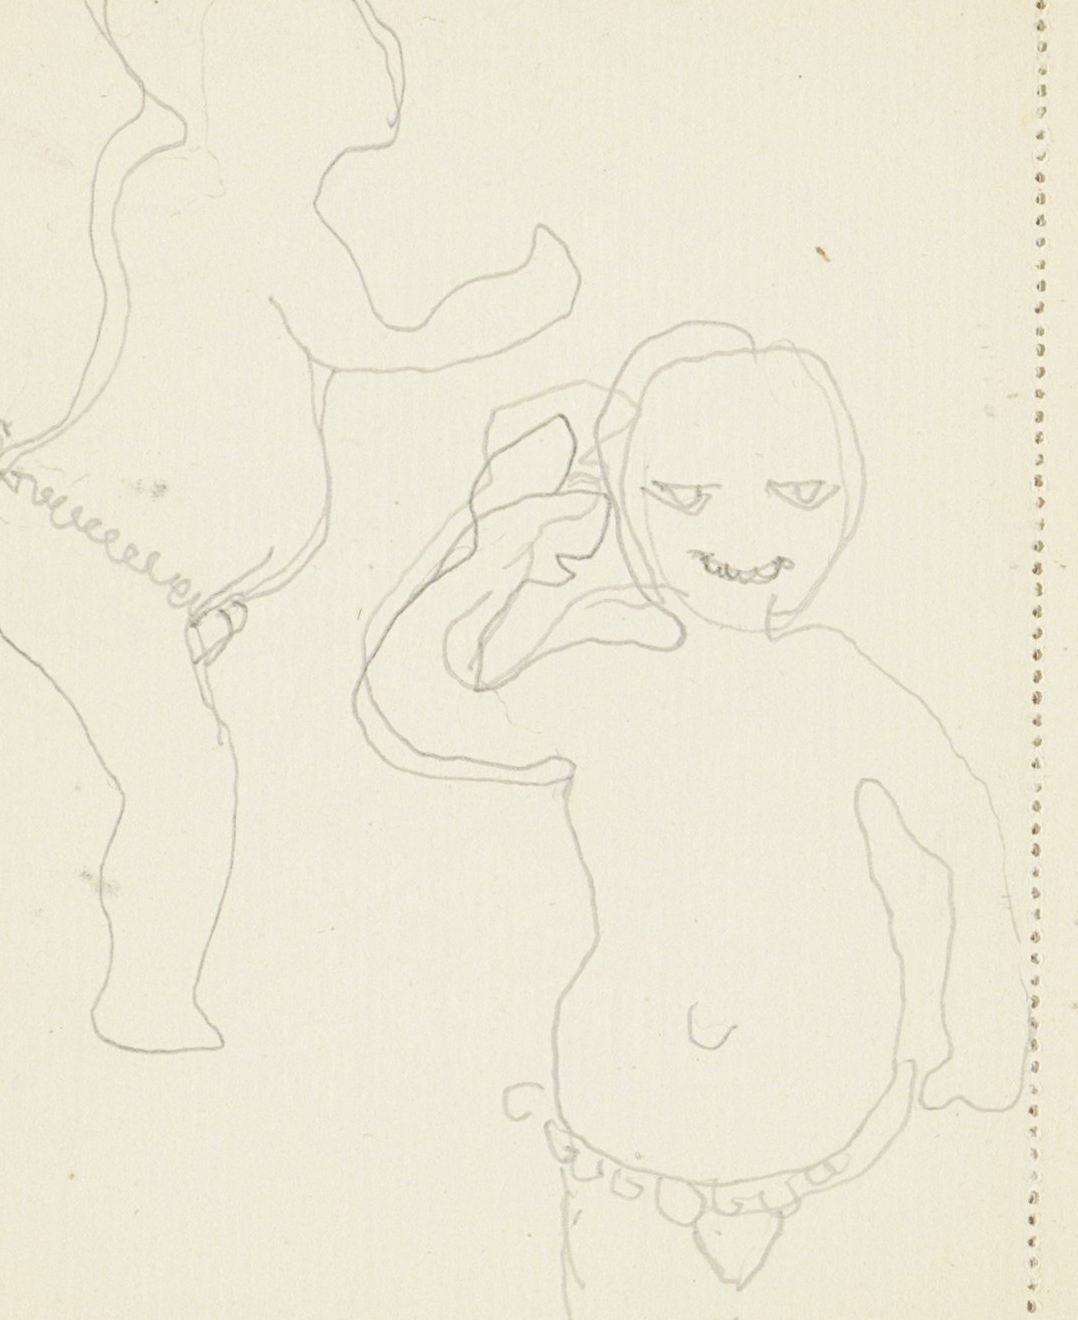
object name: sketchbook leaf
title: Afrikaans kind in een lendendoek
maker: reijer stolk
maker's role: draughtsman, print maker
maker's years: 1896-1945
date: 1916-1945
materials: paper, pencil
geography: africa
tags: africans, child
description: Blad 29 verso uit een schetsboek met 60 bladen.